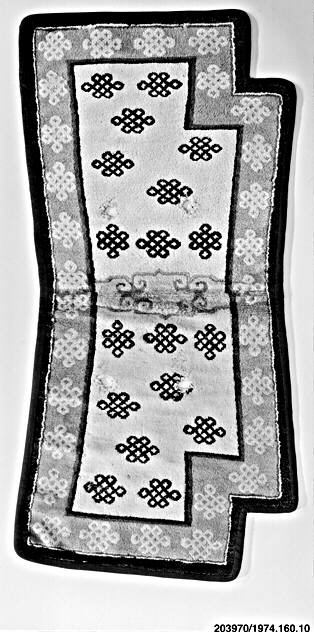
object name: rug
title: Saddle Rug with "Endless Knots"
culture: chinese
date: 1801-1900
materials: cotton, wool